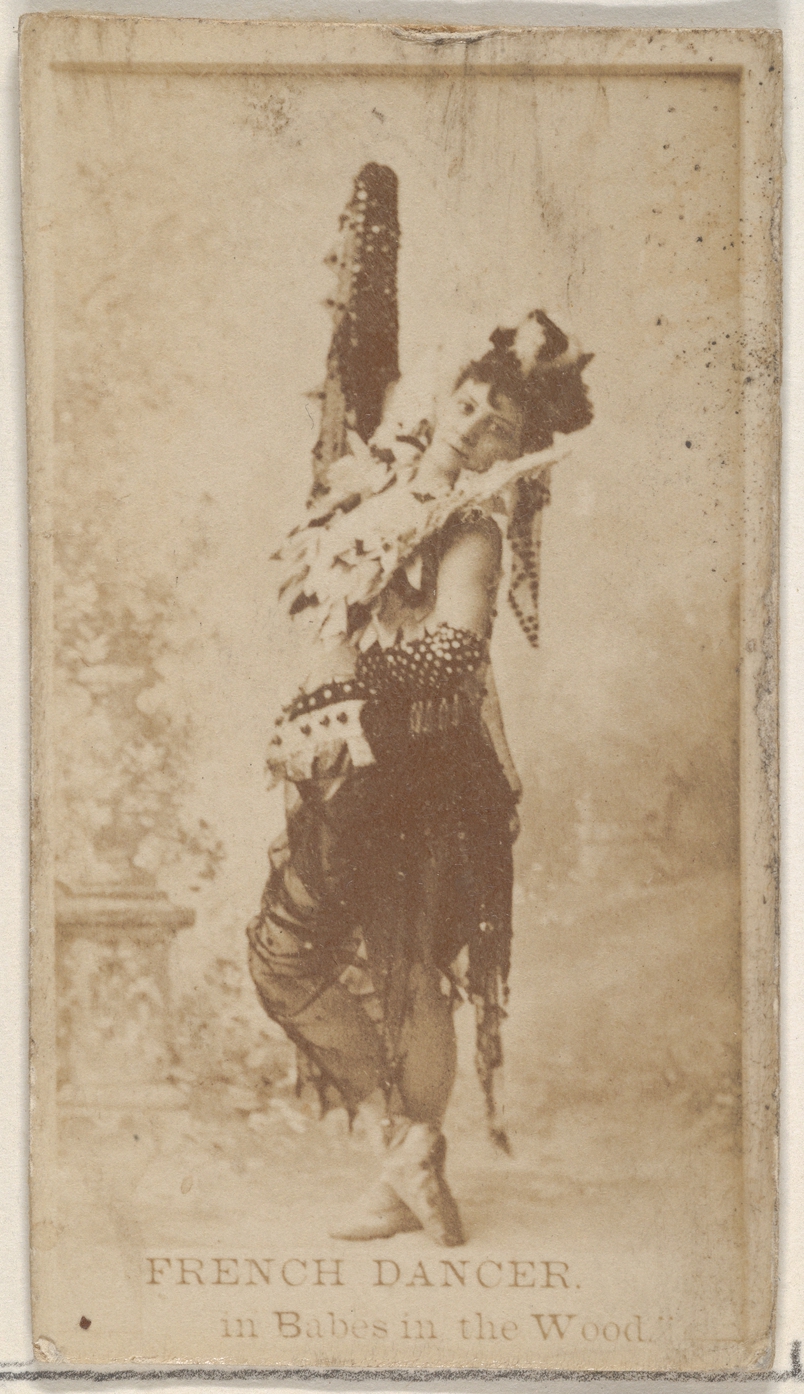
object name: photograph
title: French Dancer in Babes in the Wood, from the Actors and Actresses series (N45, Type 8) for Virginia Brights Cigarettes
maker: allen & ginter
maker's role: publisher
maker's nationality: american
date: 1888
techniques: albumen silver print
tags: portraits,women,dancers